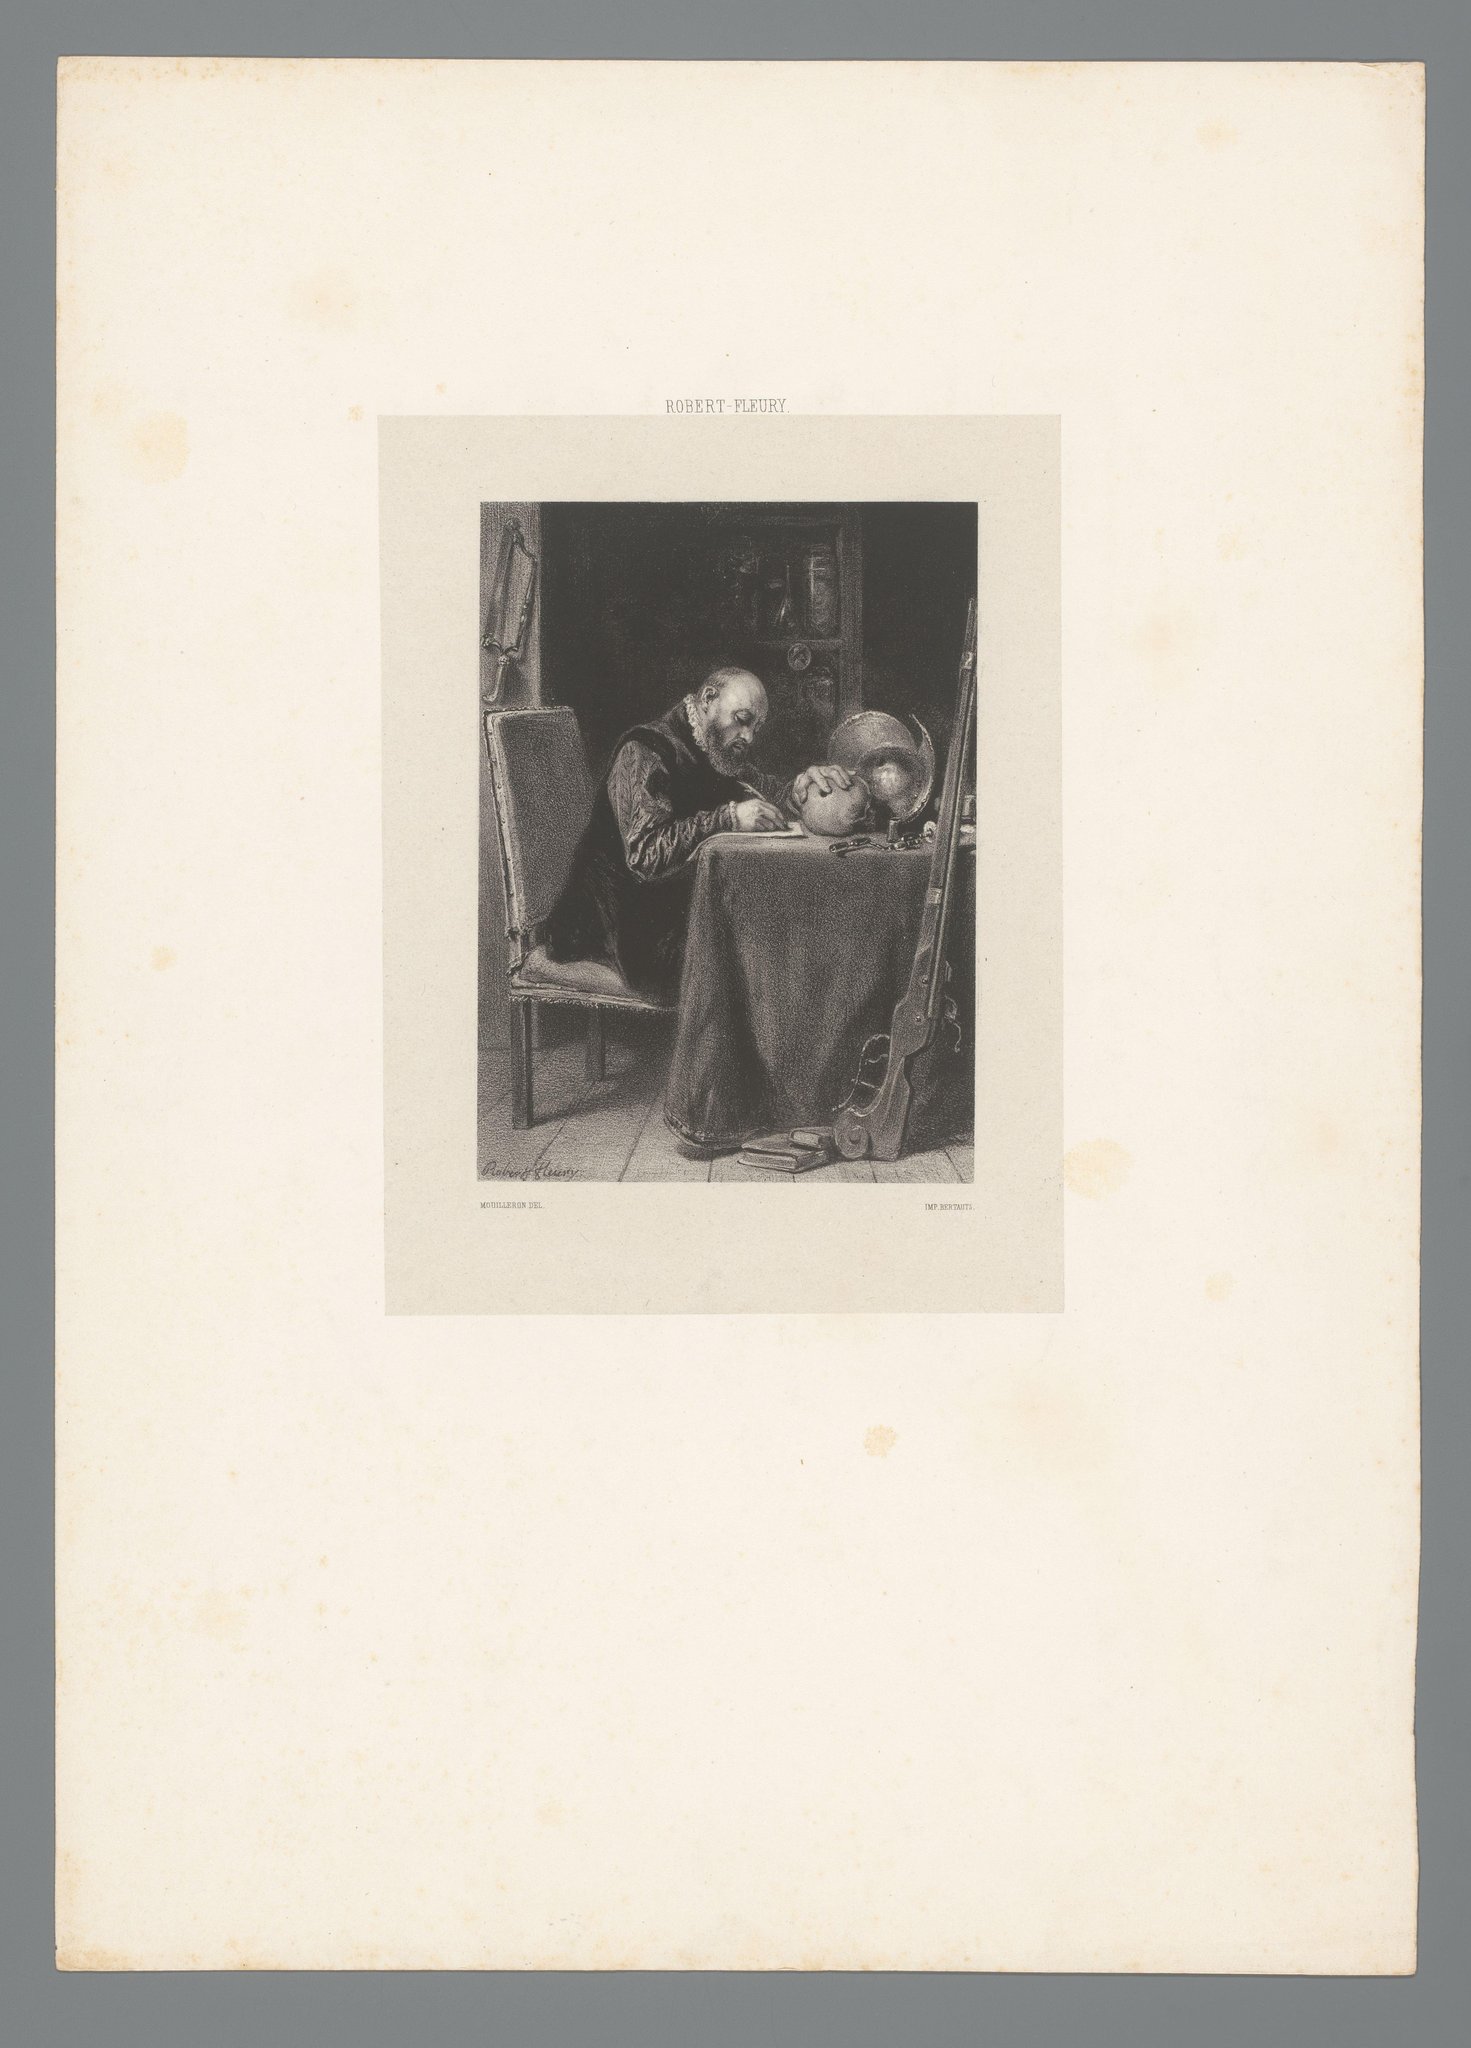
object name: print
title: Portret van Ambroise Paré aan een schrijftafel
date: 1844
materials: paper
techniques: tone lithography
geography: paris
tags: writing-table, writing-desk, historical persons, firearms: rifle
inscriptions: collector's mark: Lugt 964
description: Prent verschenen in: Les Beaux-Arts. Illustration des arts et de la littérature. Deel 3. Parijs: Léon Curmer, 1844.